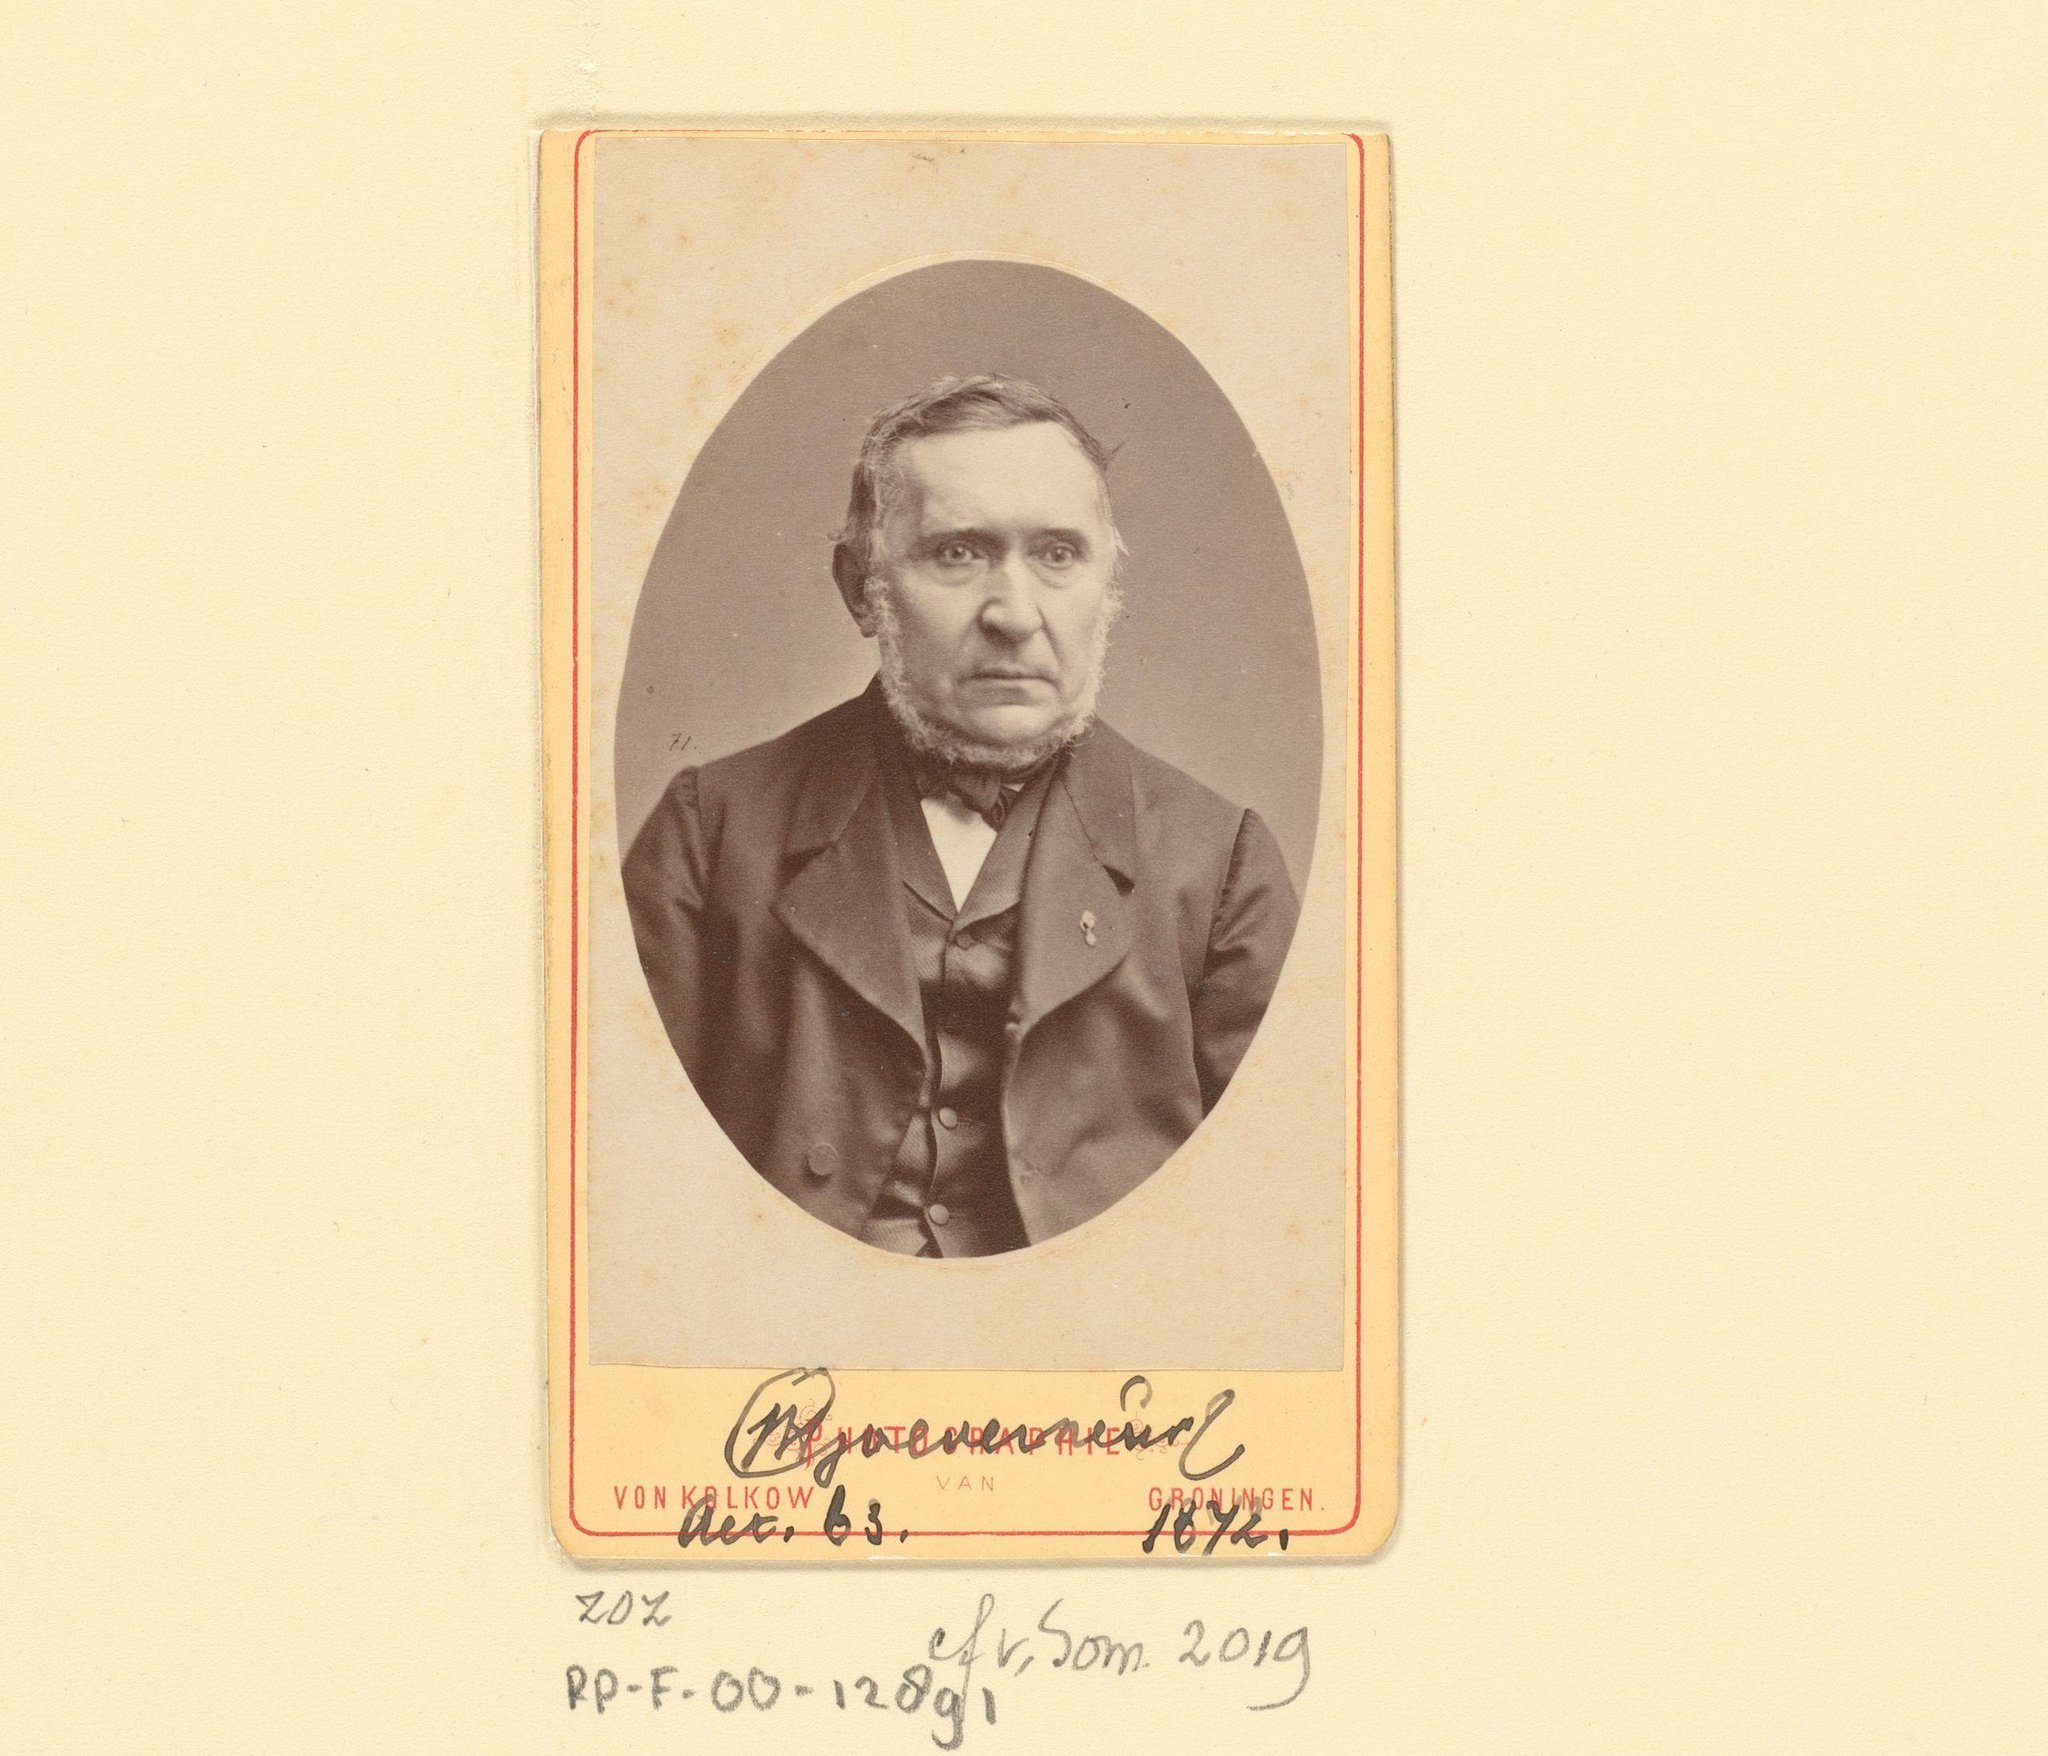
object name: photograph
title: Portret van Jan Goeverneur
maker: friedrich julius von kolkow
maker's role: fotograaf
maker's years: 1839-1914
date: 1872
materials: cardboard, paper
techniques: albumen print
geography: groningen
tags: writer, poet, author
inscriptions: inscription: ‘Amsterdam 1866/ Photographie/ van/ VON KOLKOW/ Oosterstraat E.N0 204/ GRONINGEN/ GRONINGEN 1869/ Iedere plaat wordt voor nabestelling bewaard.’, inscription: ‘J.J.A. Goeverneur.’, inscription: ‘Goeverneur/ [...]63 1872.’